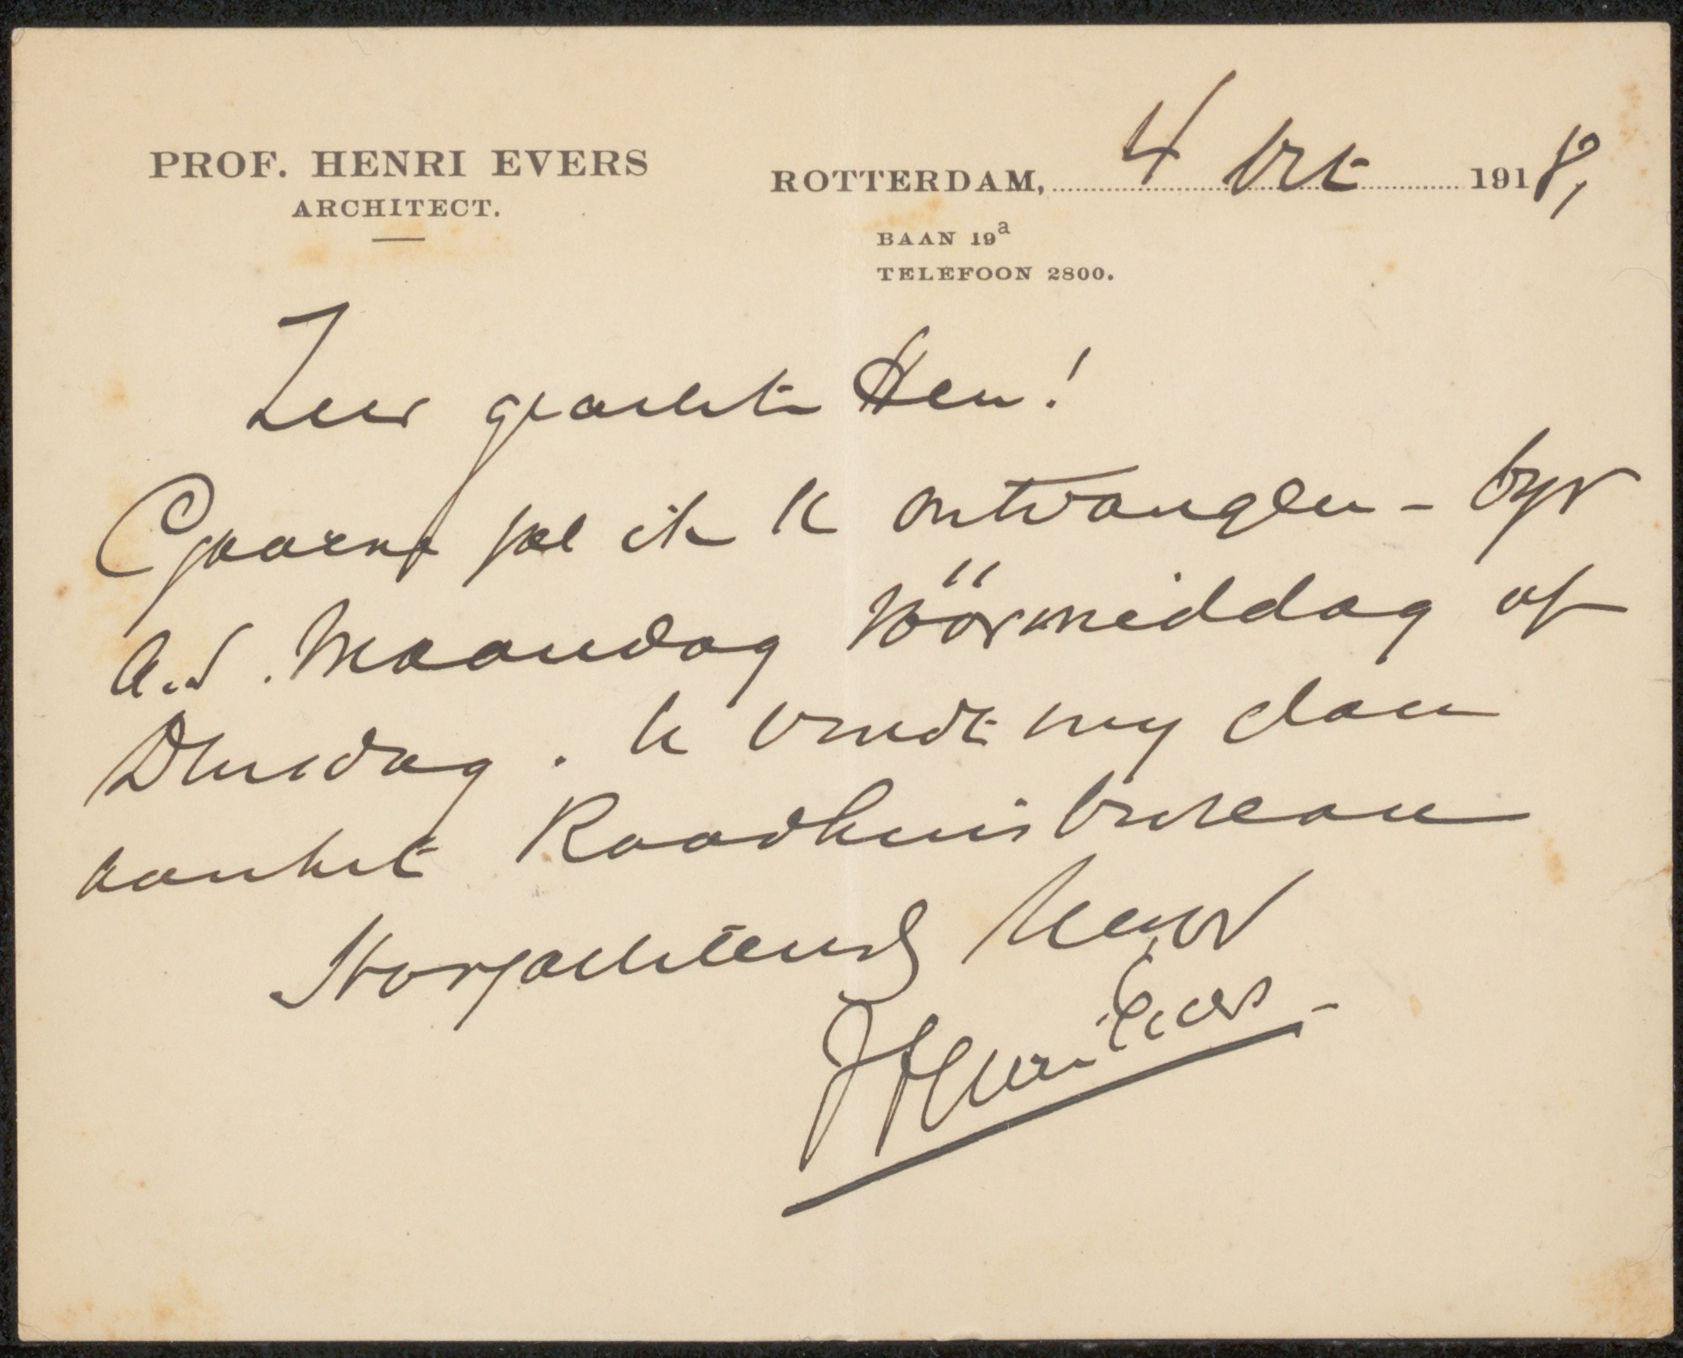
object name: letter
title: Brief aan Philip Zilcken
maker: henri evers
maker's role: architect, hoogleraar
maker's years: 1855-1929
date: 1918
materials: cardboard, ink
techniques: pen, printing, writing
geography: rotterdam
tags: the hague, painter, philip zilcken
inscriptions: collector's mark: ‘RPK’